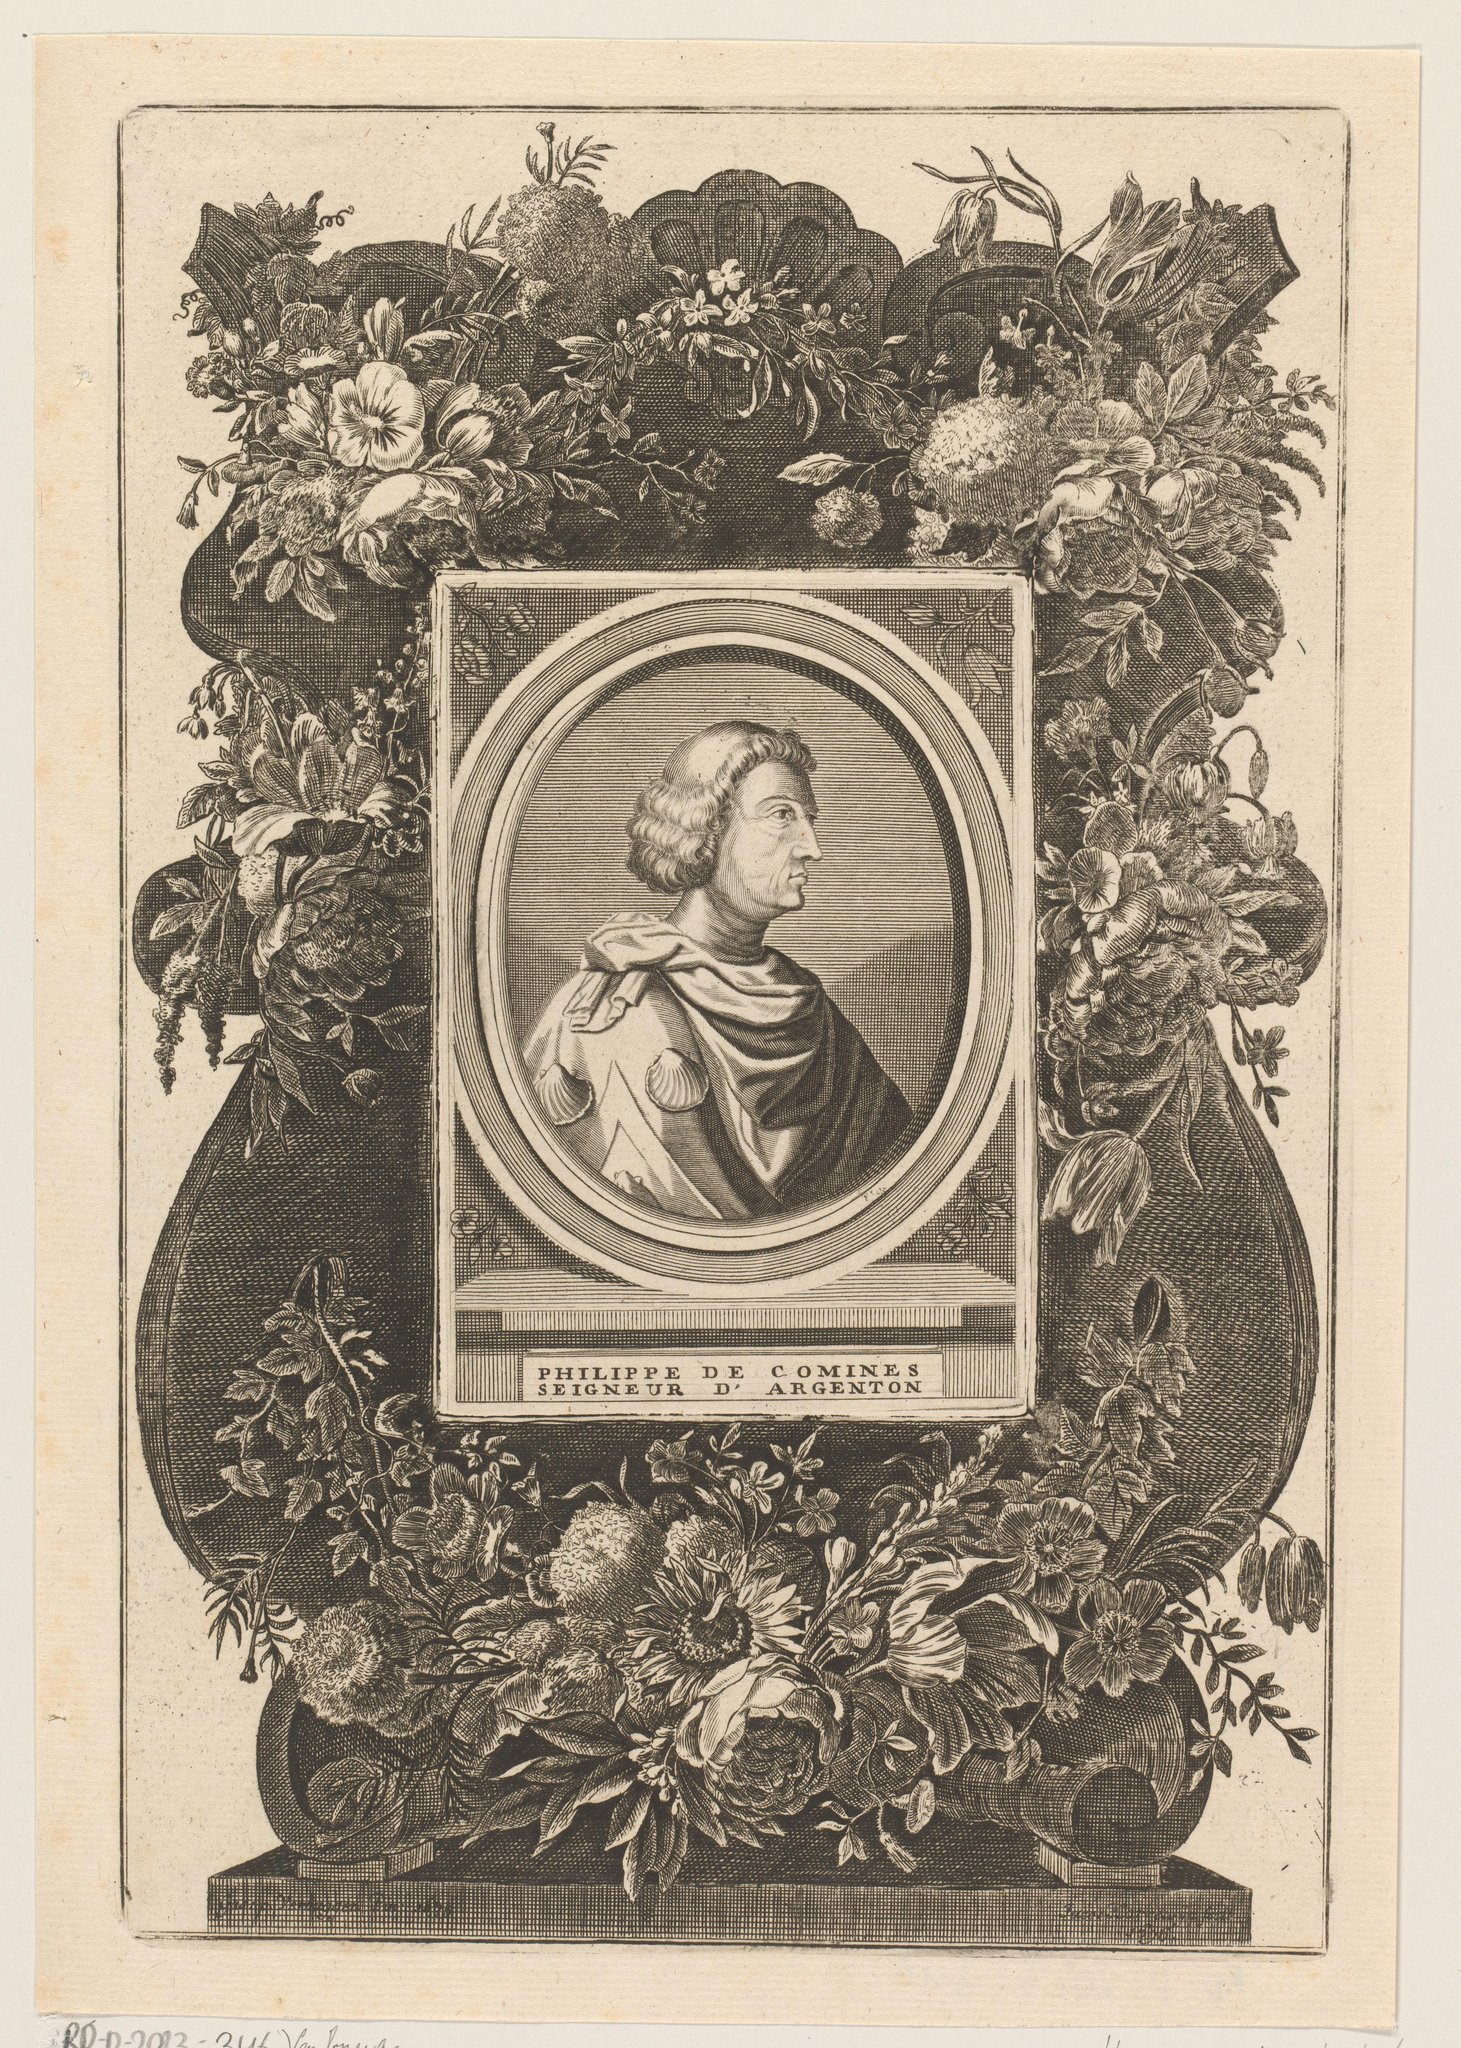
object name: print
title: Portret van Filips van Komen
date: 1696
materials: paper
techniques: engraving, etching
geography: antwerp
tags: historical persons, diplomacy, diplomat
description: Prent waarschijnlijk uit: Komen, Filips van. Las Memorias (...). Antwerpen: Hendrik en Cornelis Verdussen, 1713, dl. 1. Of uit de editie uit 1714.